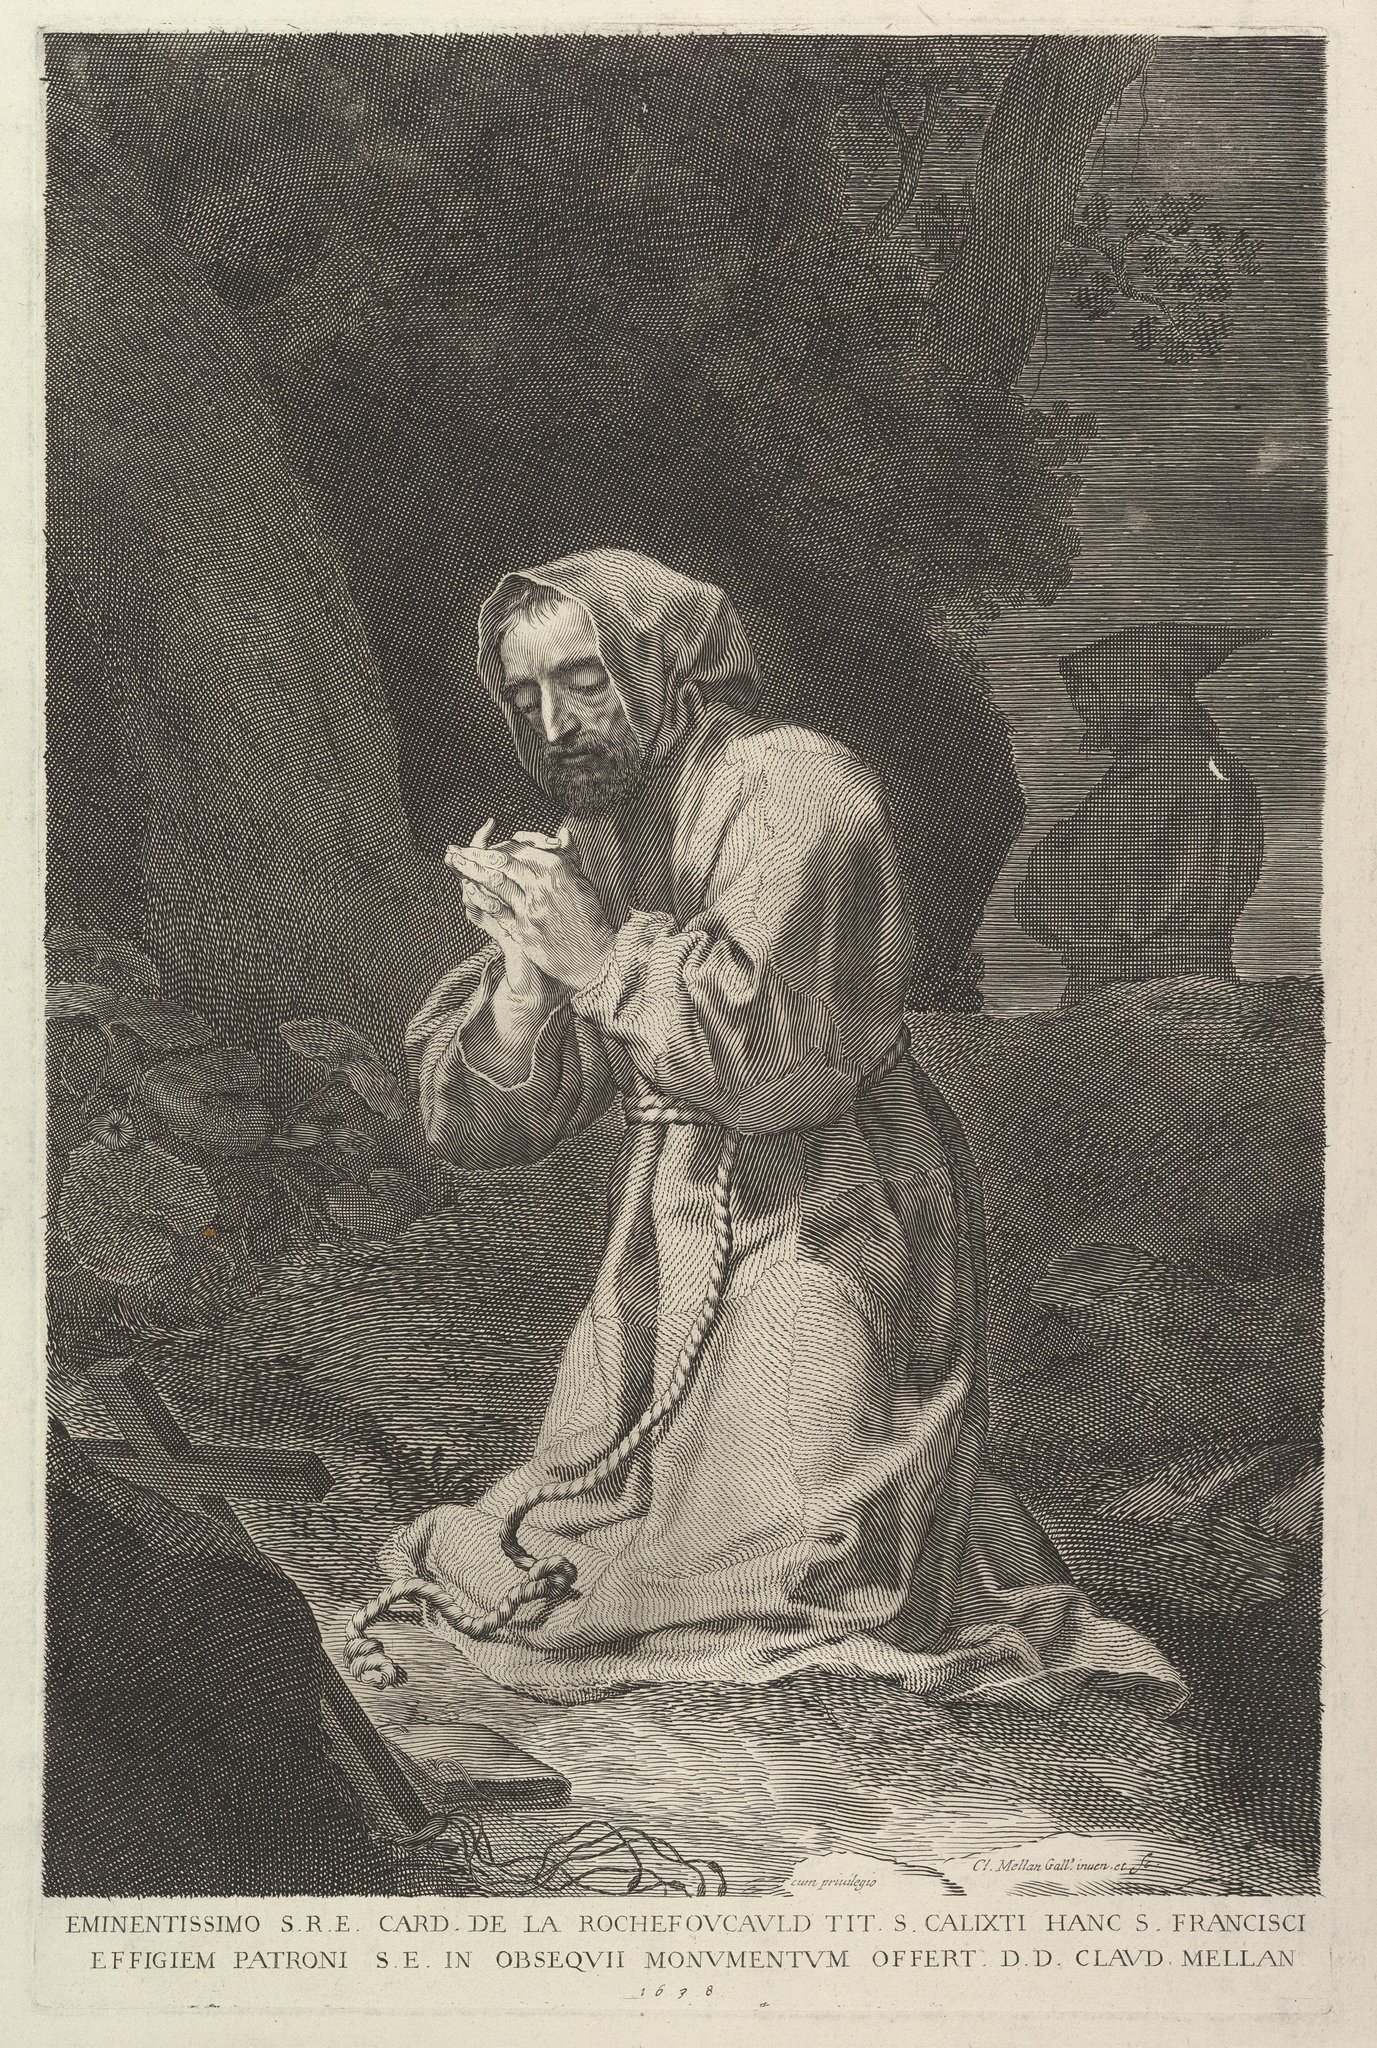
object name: print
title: St. Francis of Assisi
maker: claude mellan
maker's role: artist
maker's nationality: french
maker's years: 1598-1688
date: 1638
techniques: engraving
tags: saint francis,cross,praying